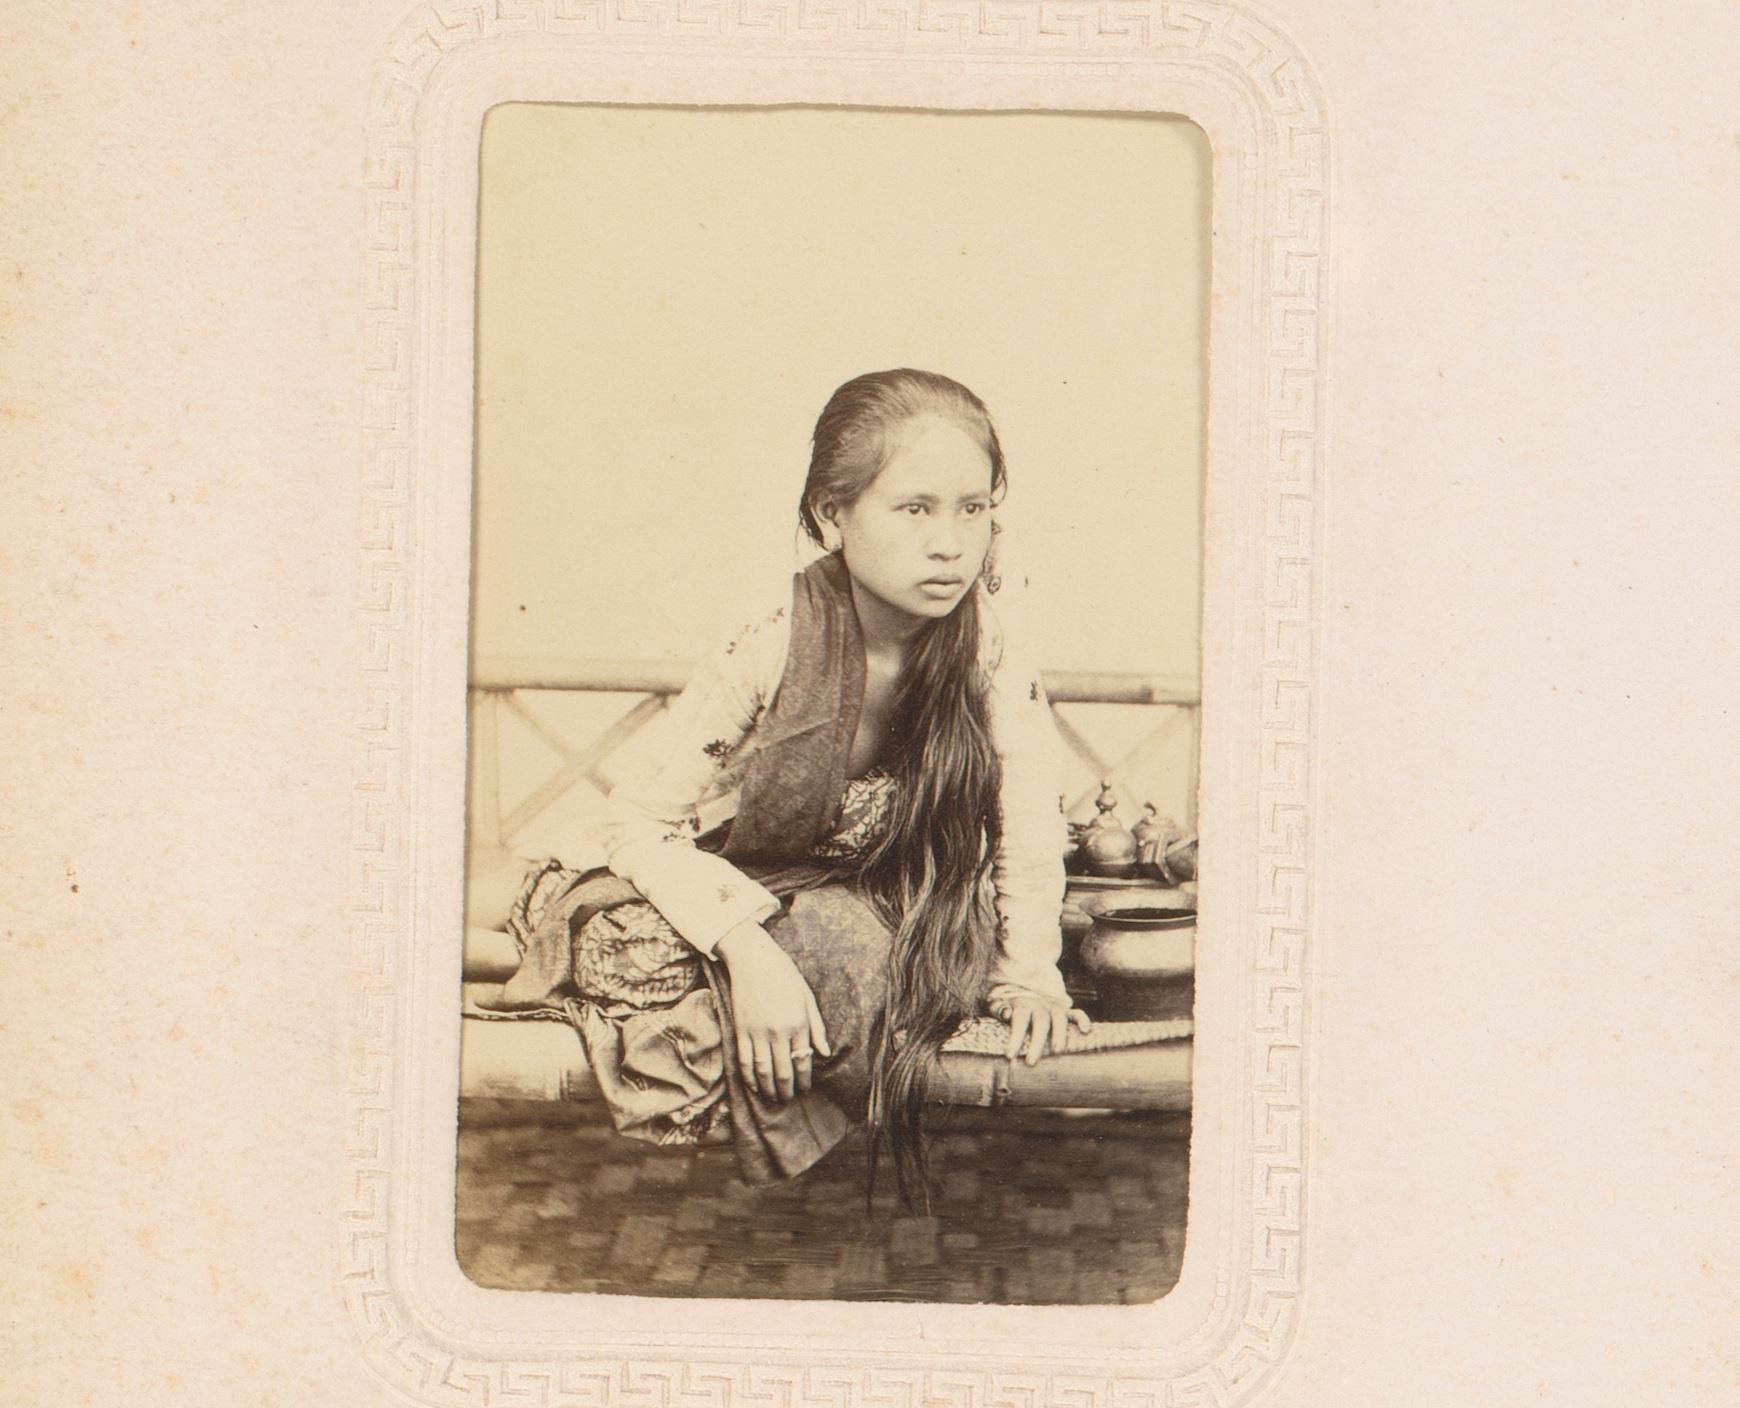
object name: photograph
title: Portret van een Indonesisch meisje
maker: Anonymous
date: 1850-1870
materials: cardboard, photographic support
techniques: albumen print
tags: historical persons - bb - woman, girl (child between toddler and youth)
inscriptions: number: ‘5’